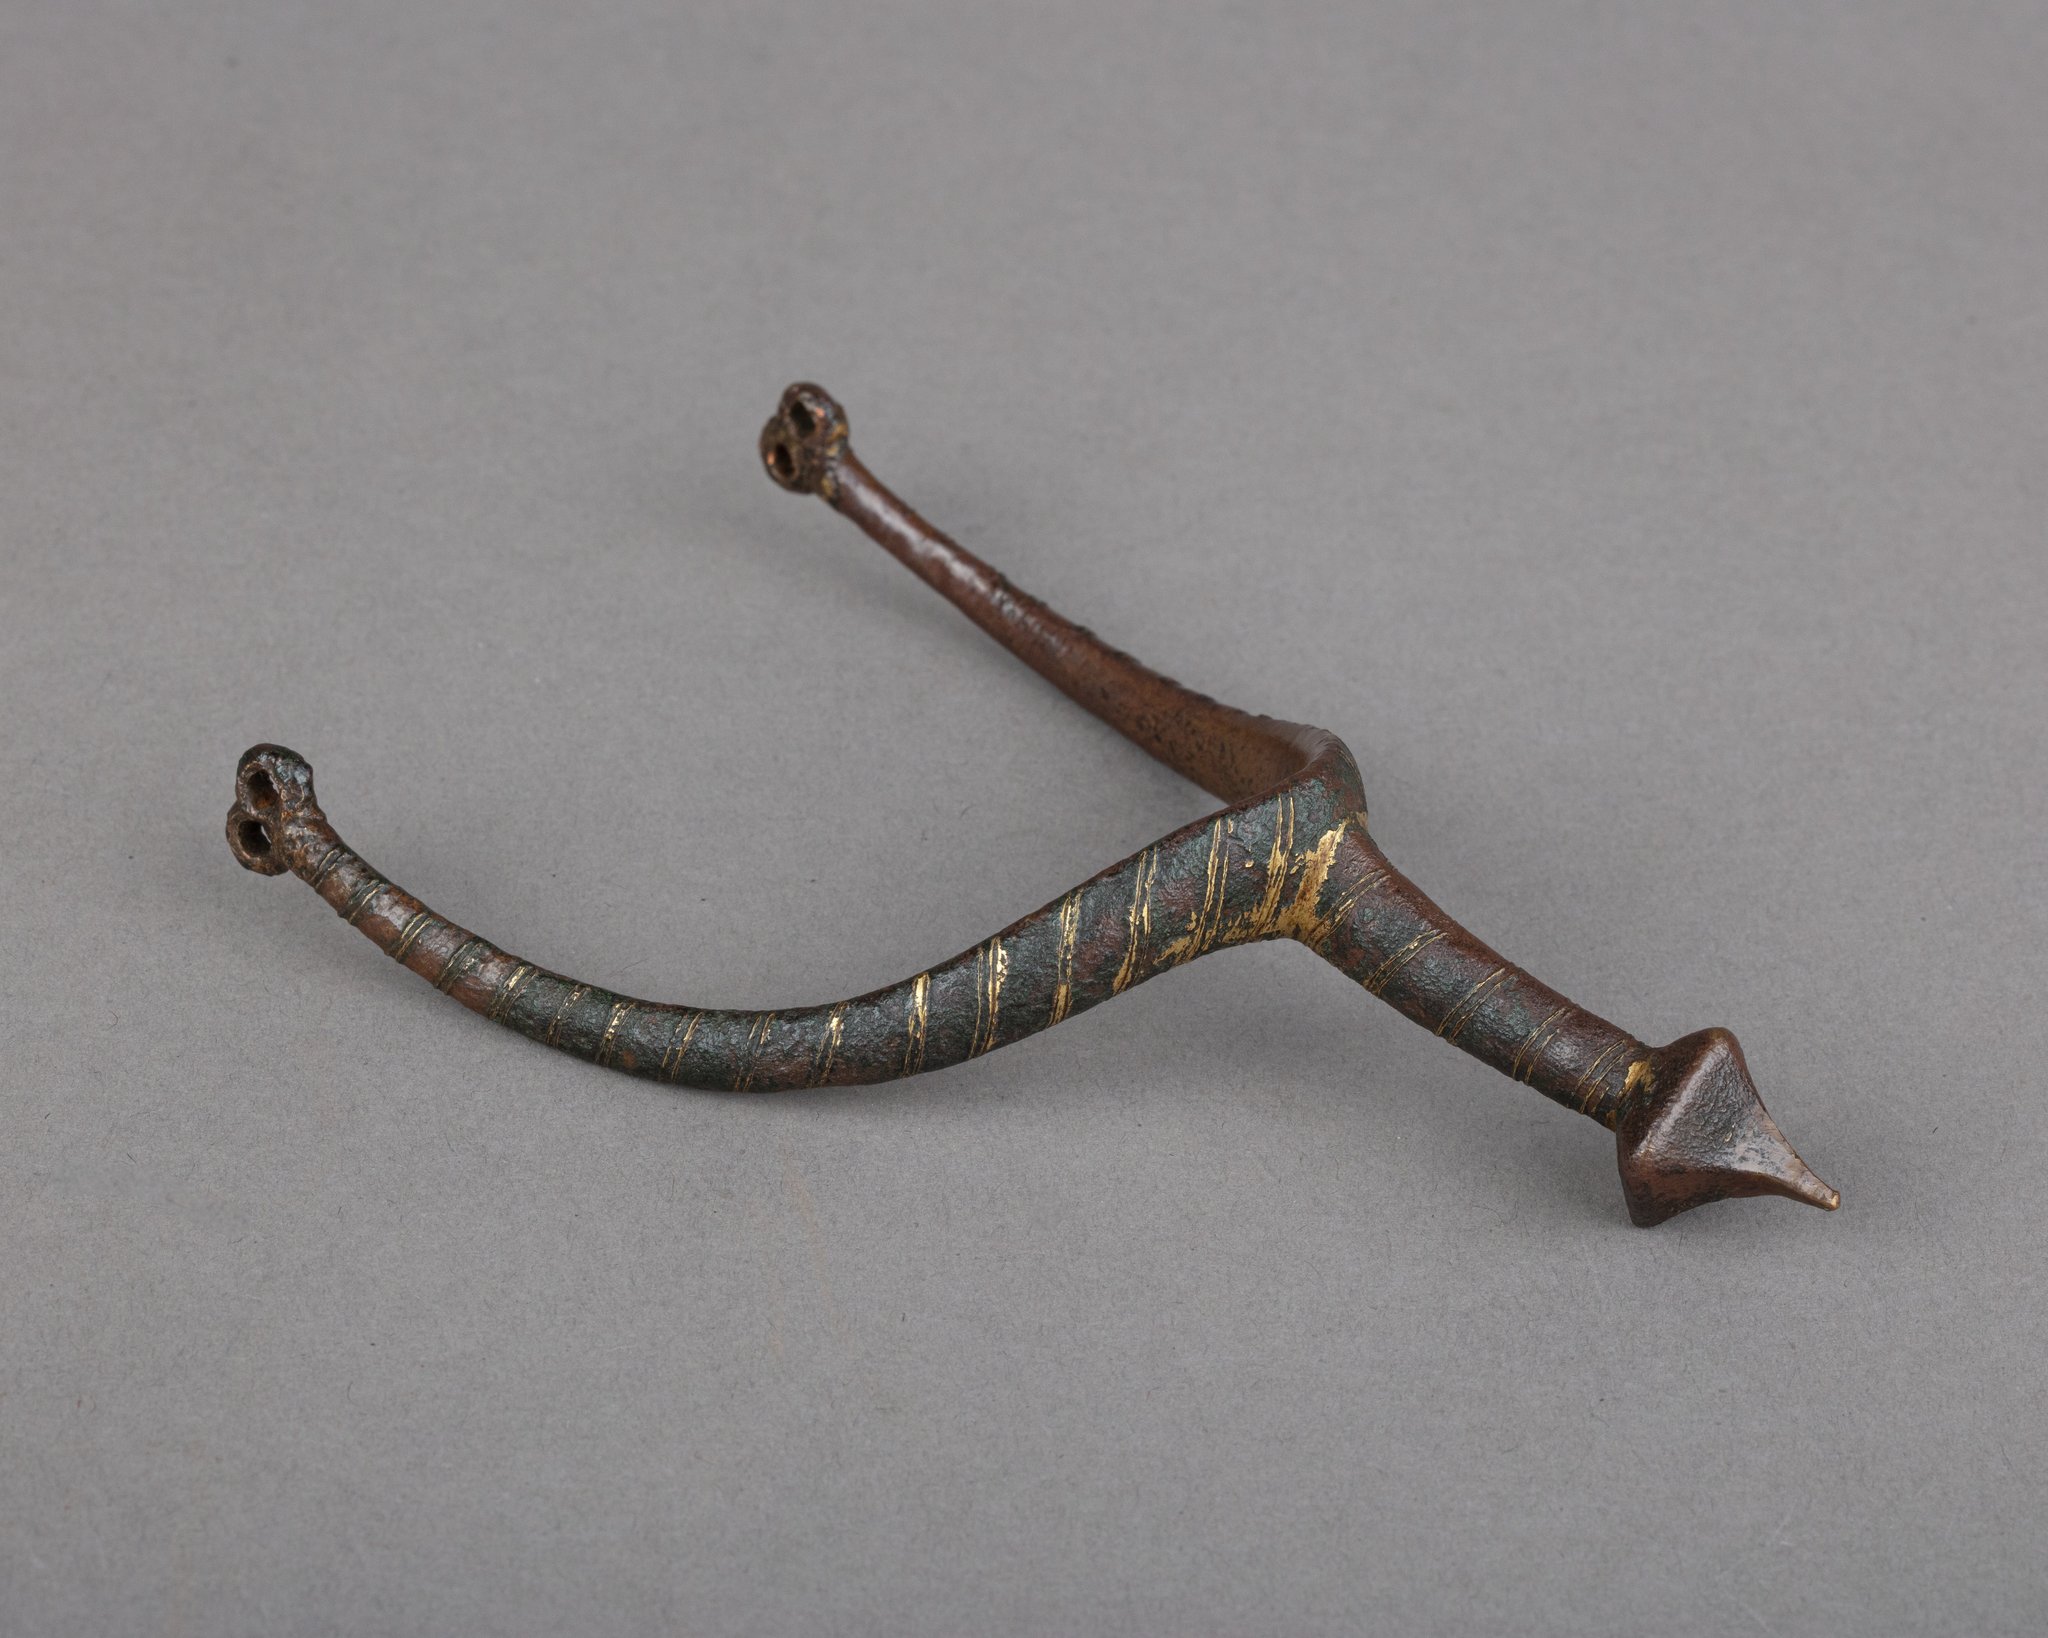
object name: spur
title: Prick Spur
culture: german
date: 1101-1200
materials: copper alloy, gold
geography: germany